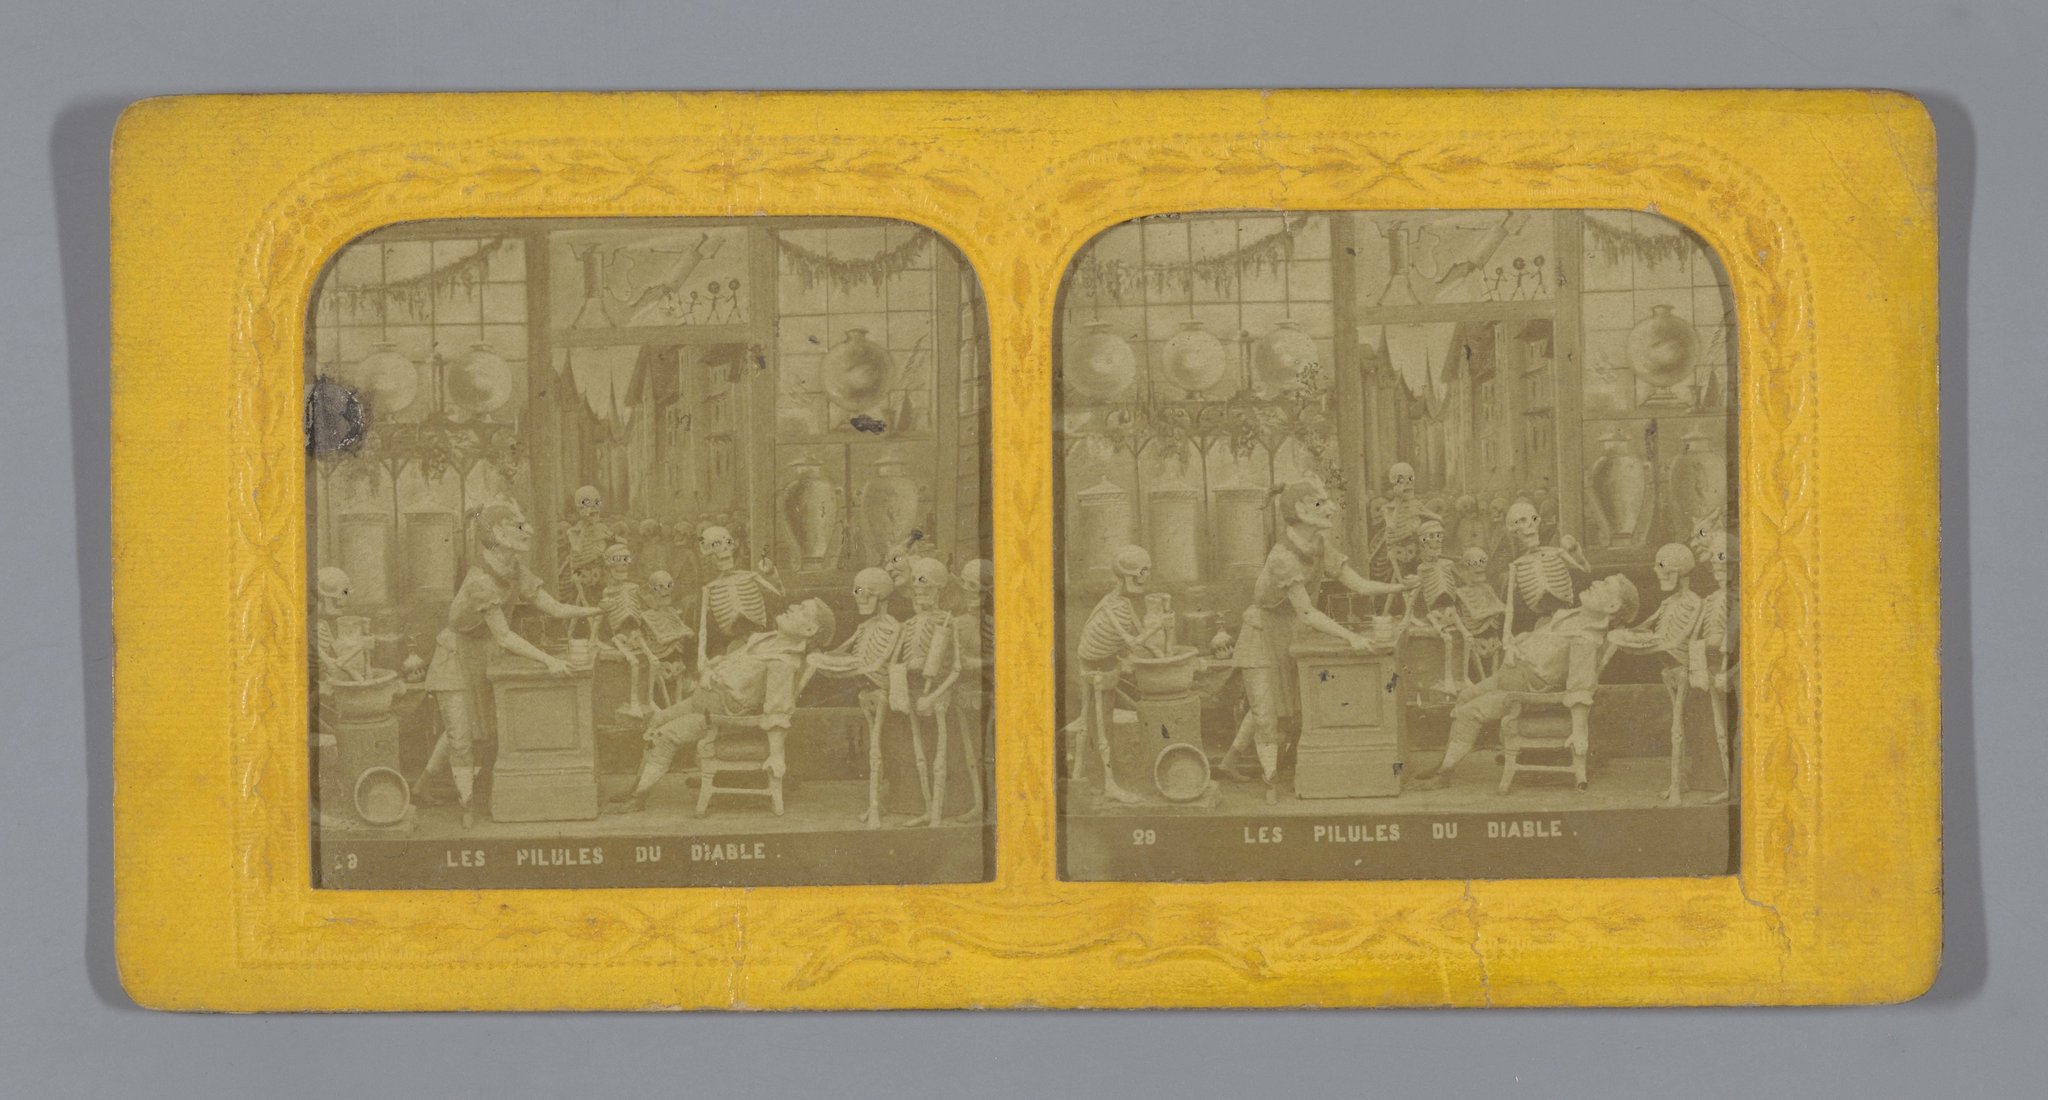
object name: tissue stereograph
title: Les Pilules du Diable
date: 1868-1873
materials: cardboard, paper, photographic support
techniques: albumen print, hand coloring, perforating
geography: paris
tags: pharmacy, pharmaceutics, (human) skeleton, france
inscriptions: number: ‘29’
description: De serie 'Les Diableries' verbeeldt scènes van het dagelijkse leven in de hel, bedoeld als moralistisch en satirisch commentaar op het autoritaire bewind van Napoleon III in Frankrijk. De taferelen werden minutieus uit klei gefabriceerd en vervolgens met een stereocamera gefotografeerd.